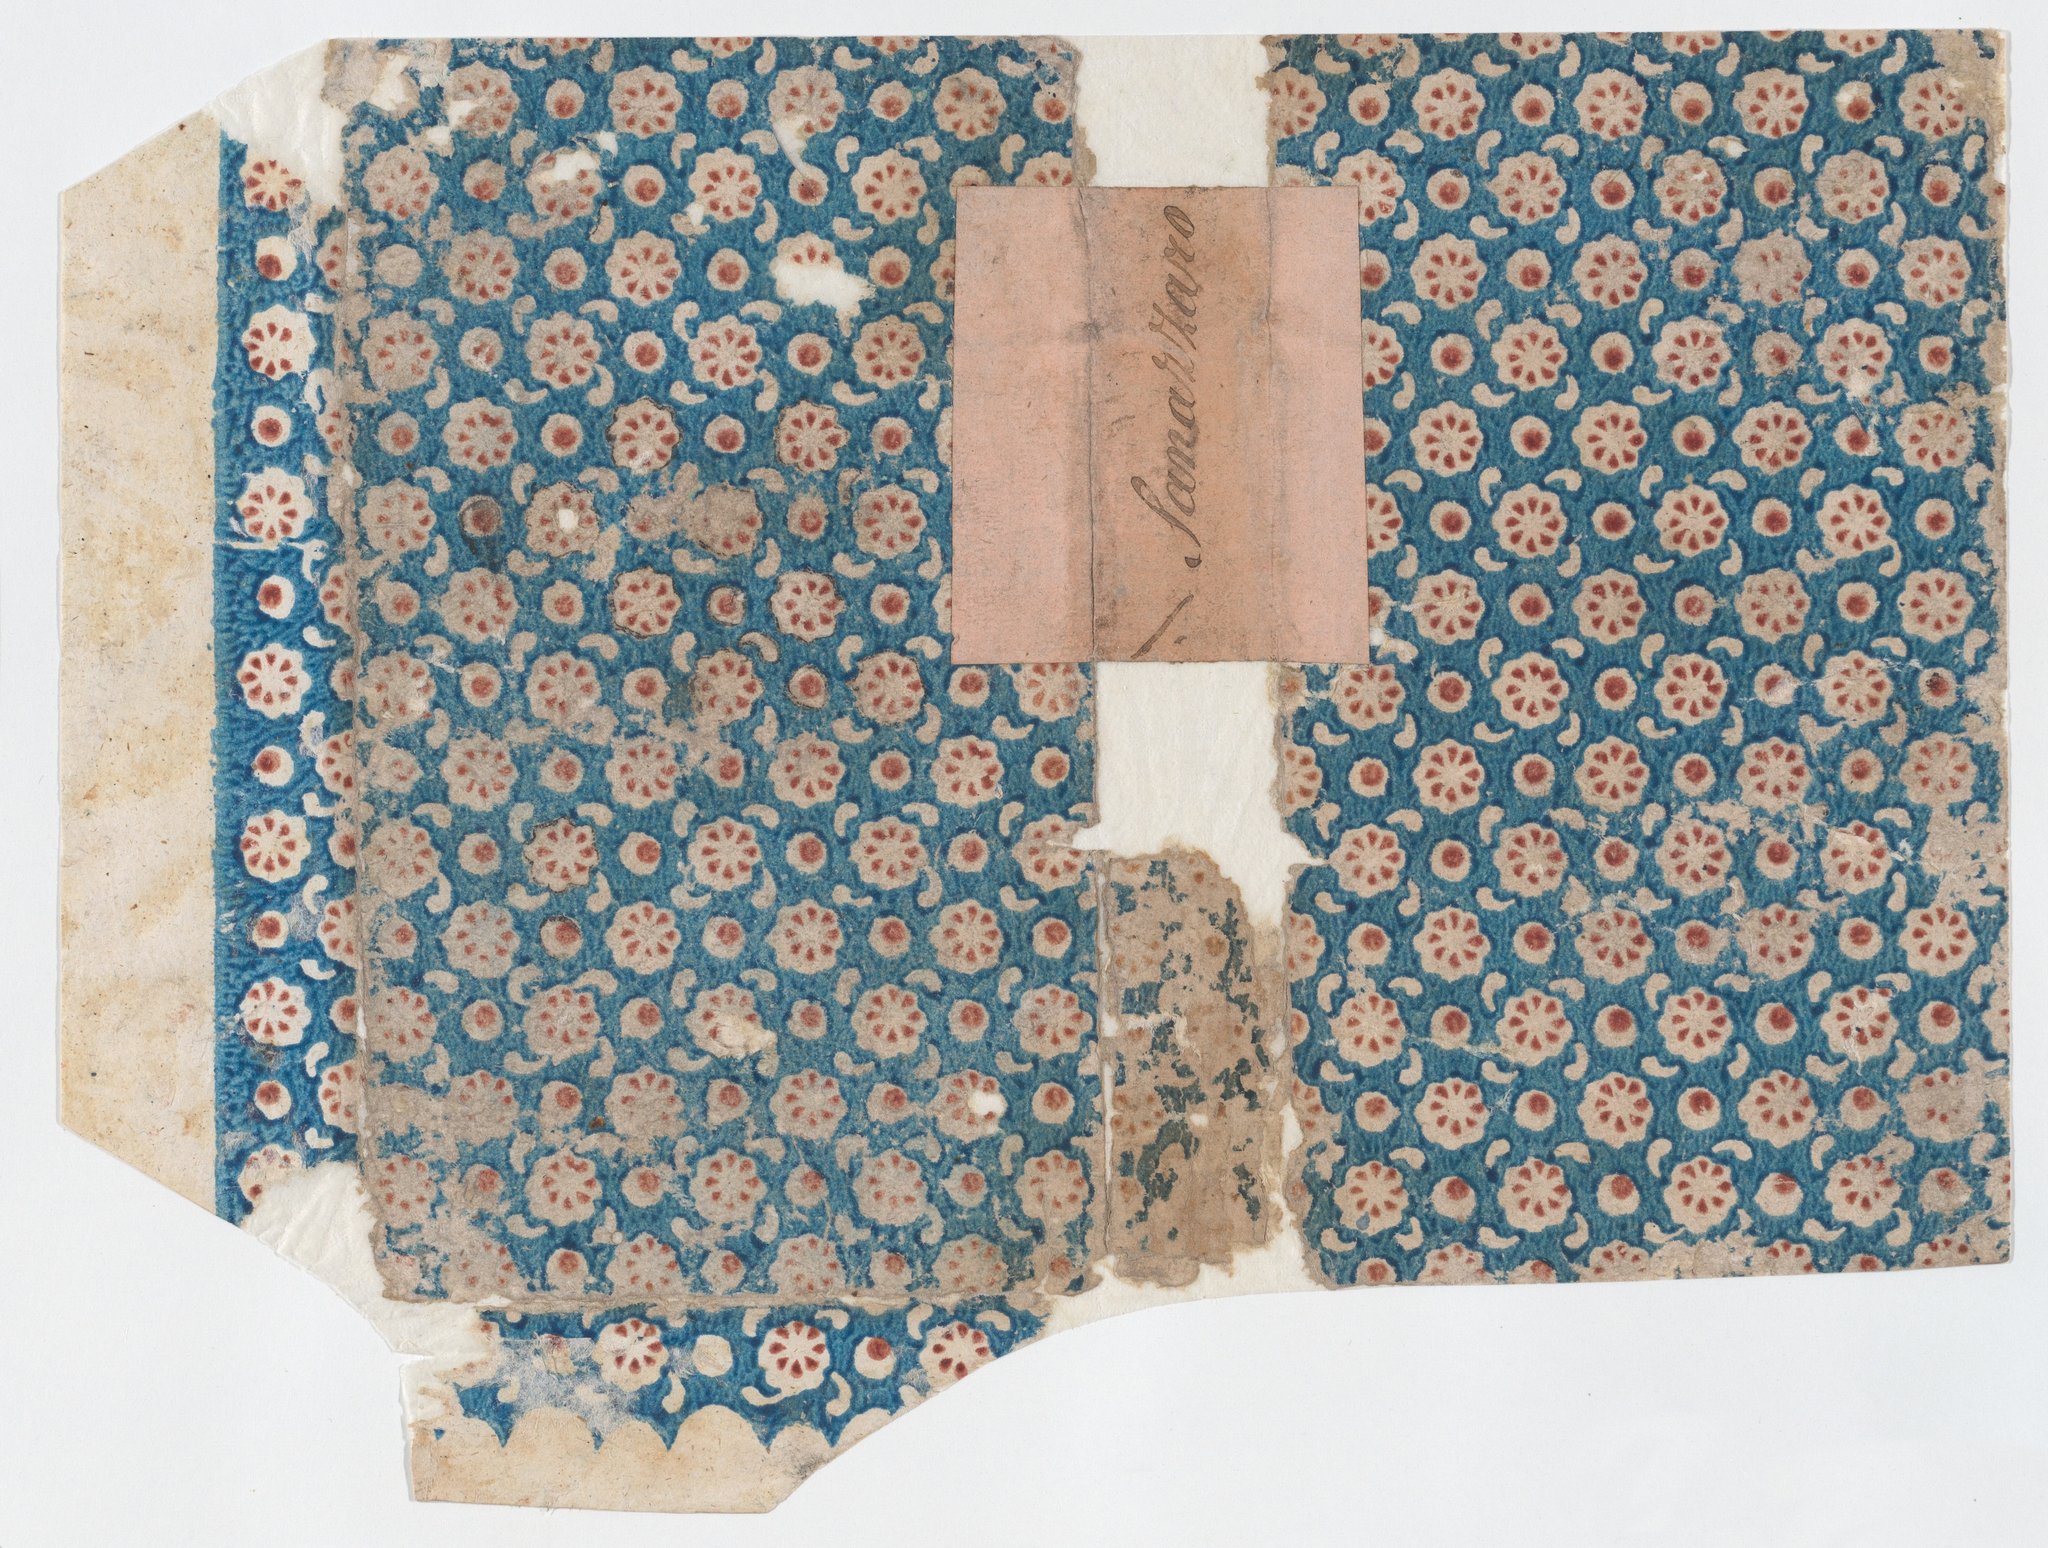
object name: print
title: Book cover with overall floral and dot pattern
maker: Anonymous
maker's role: artist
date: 1801-1900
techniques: relief print